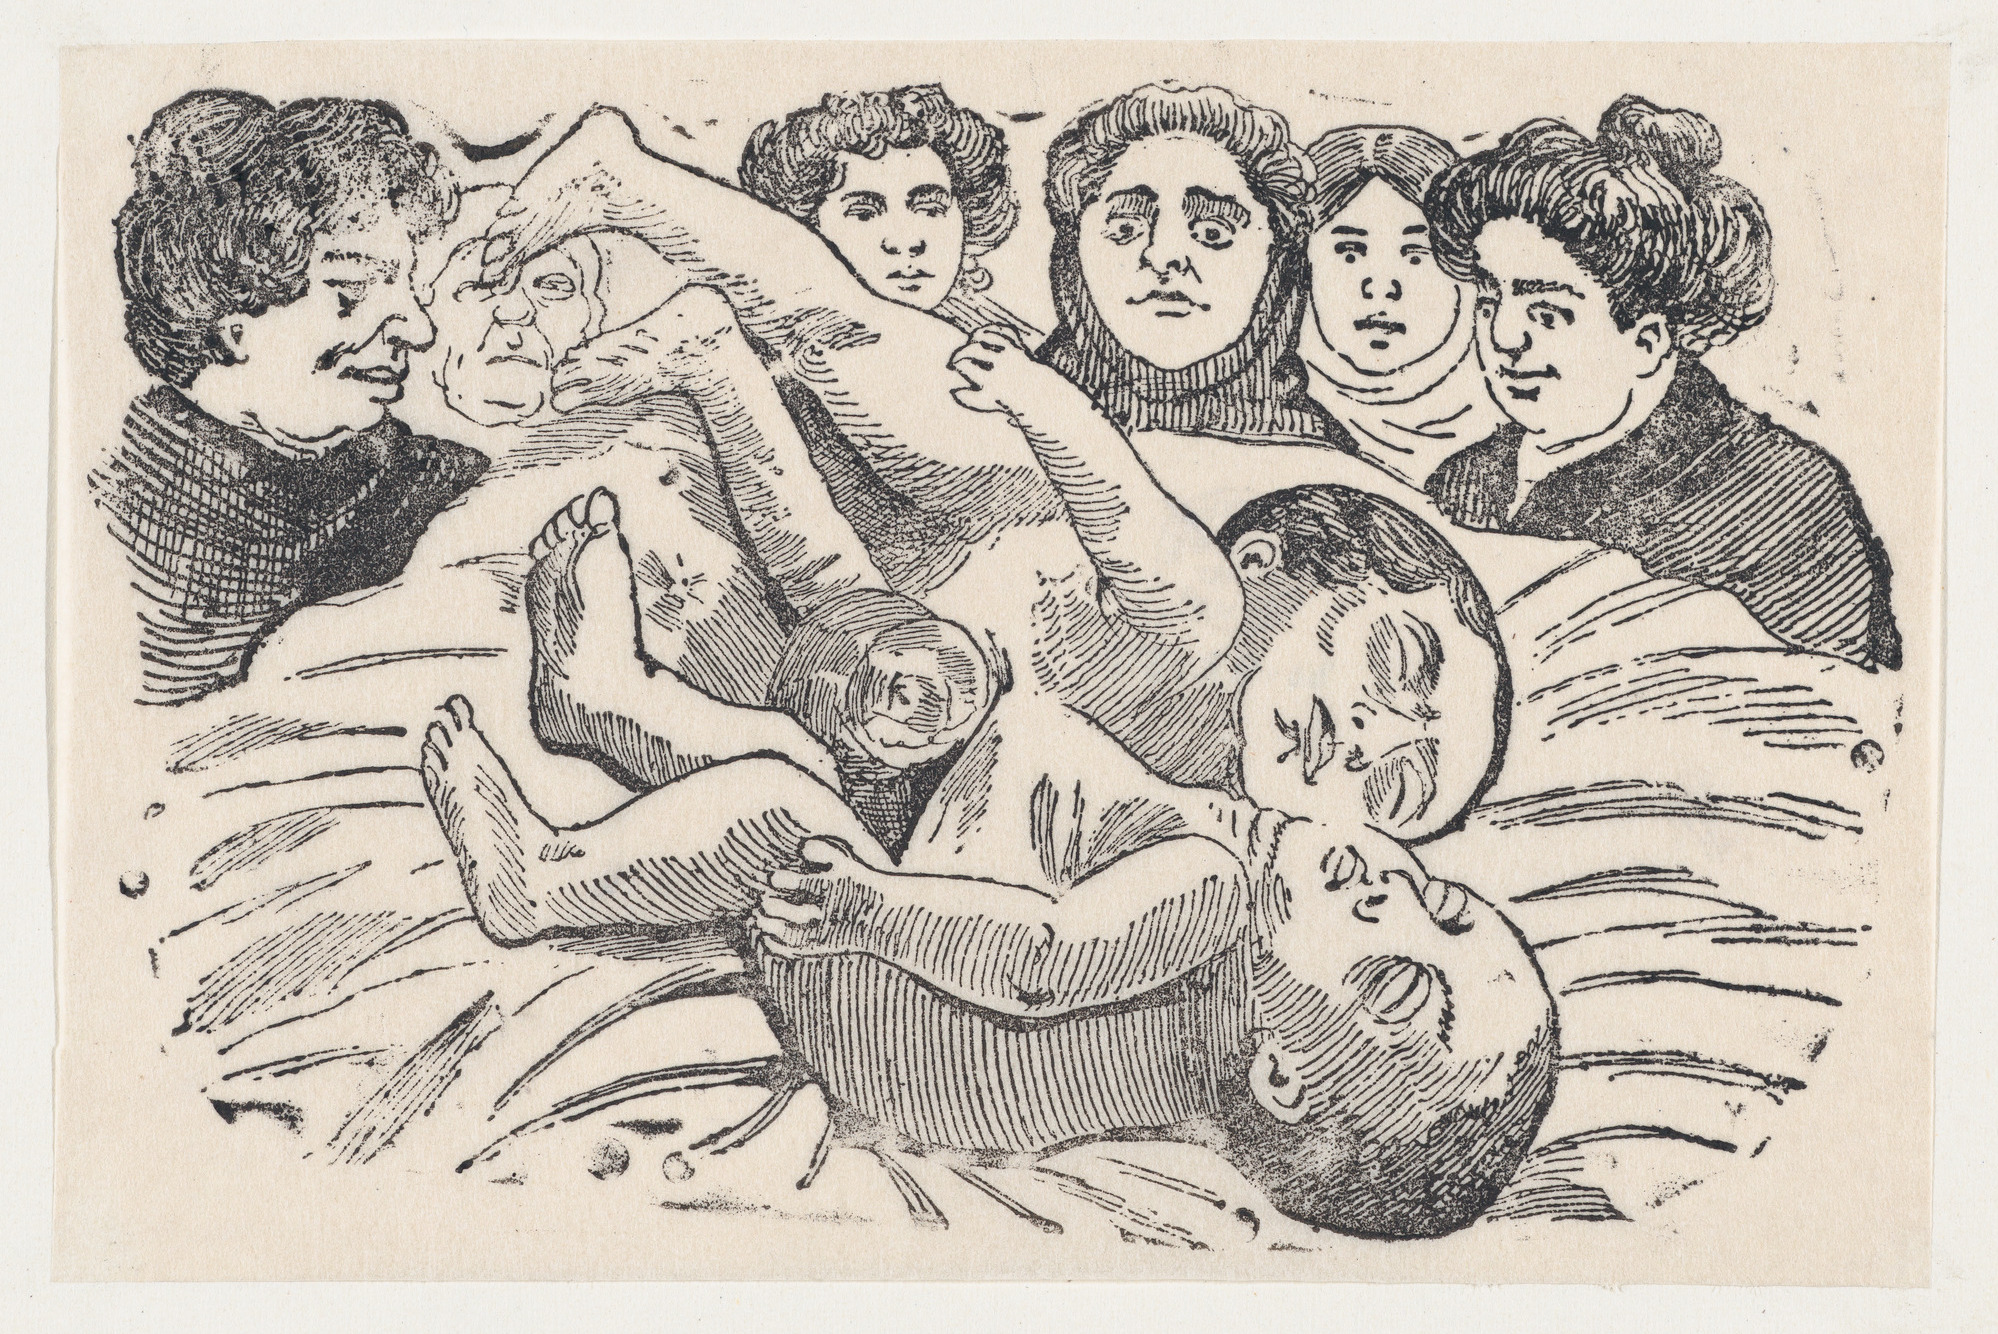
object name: print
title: Siamese Twins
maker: josé guadalupe posada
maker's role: artist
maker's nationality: mexican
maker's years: 1852-1913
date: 1880-1910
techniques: lithography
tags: infants,women